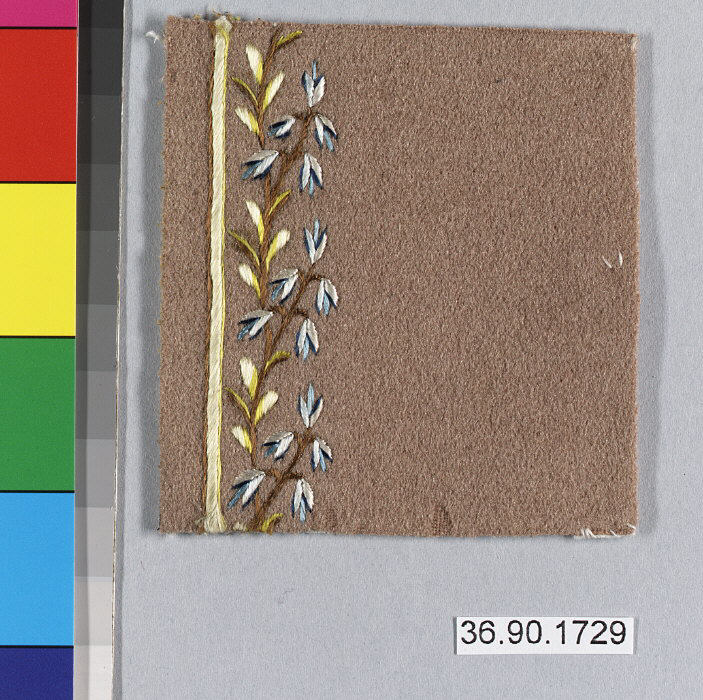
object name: sample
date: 1801-1833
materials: felt, silk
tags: plants